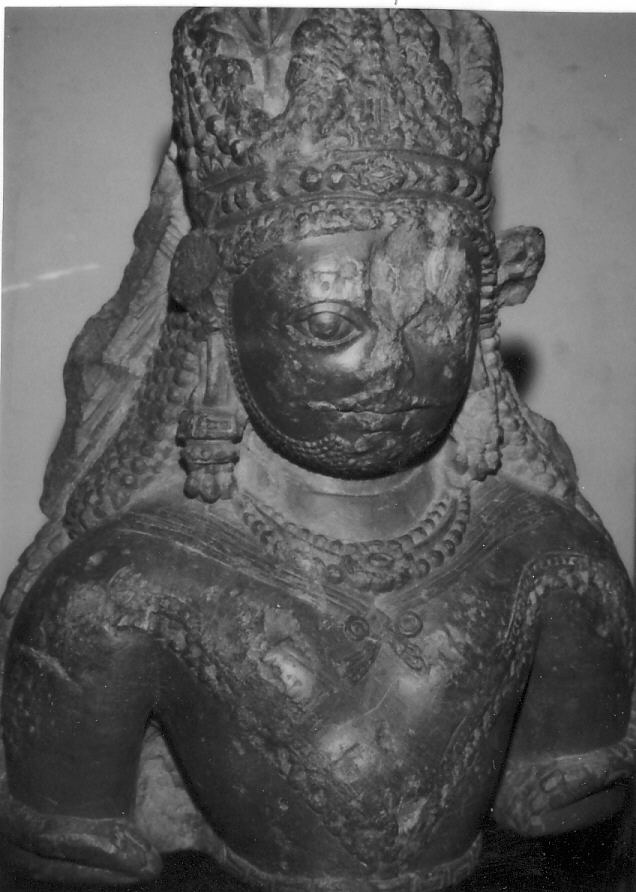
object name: bust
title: Bust of Surya (The God of the Sun)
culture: kashmiri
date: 751-800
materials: stone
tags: kashmir